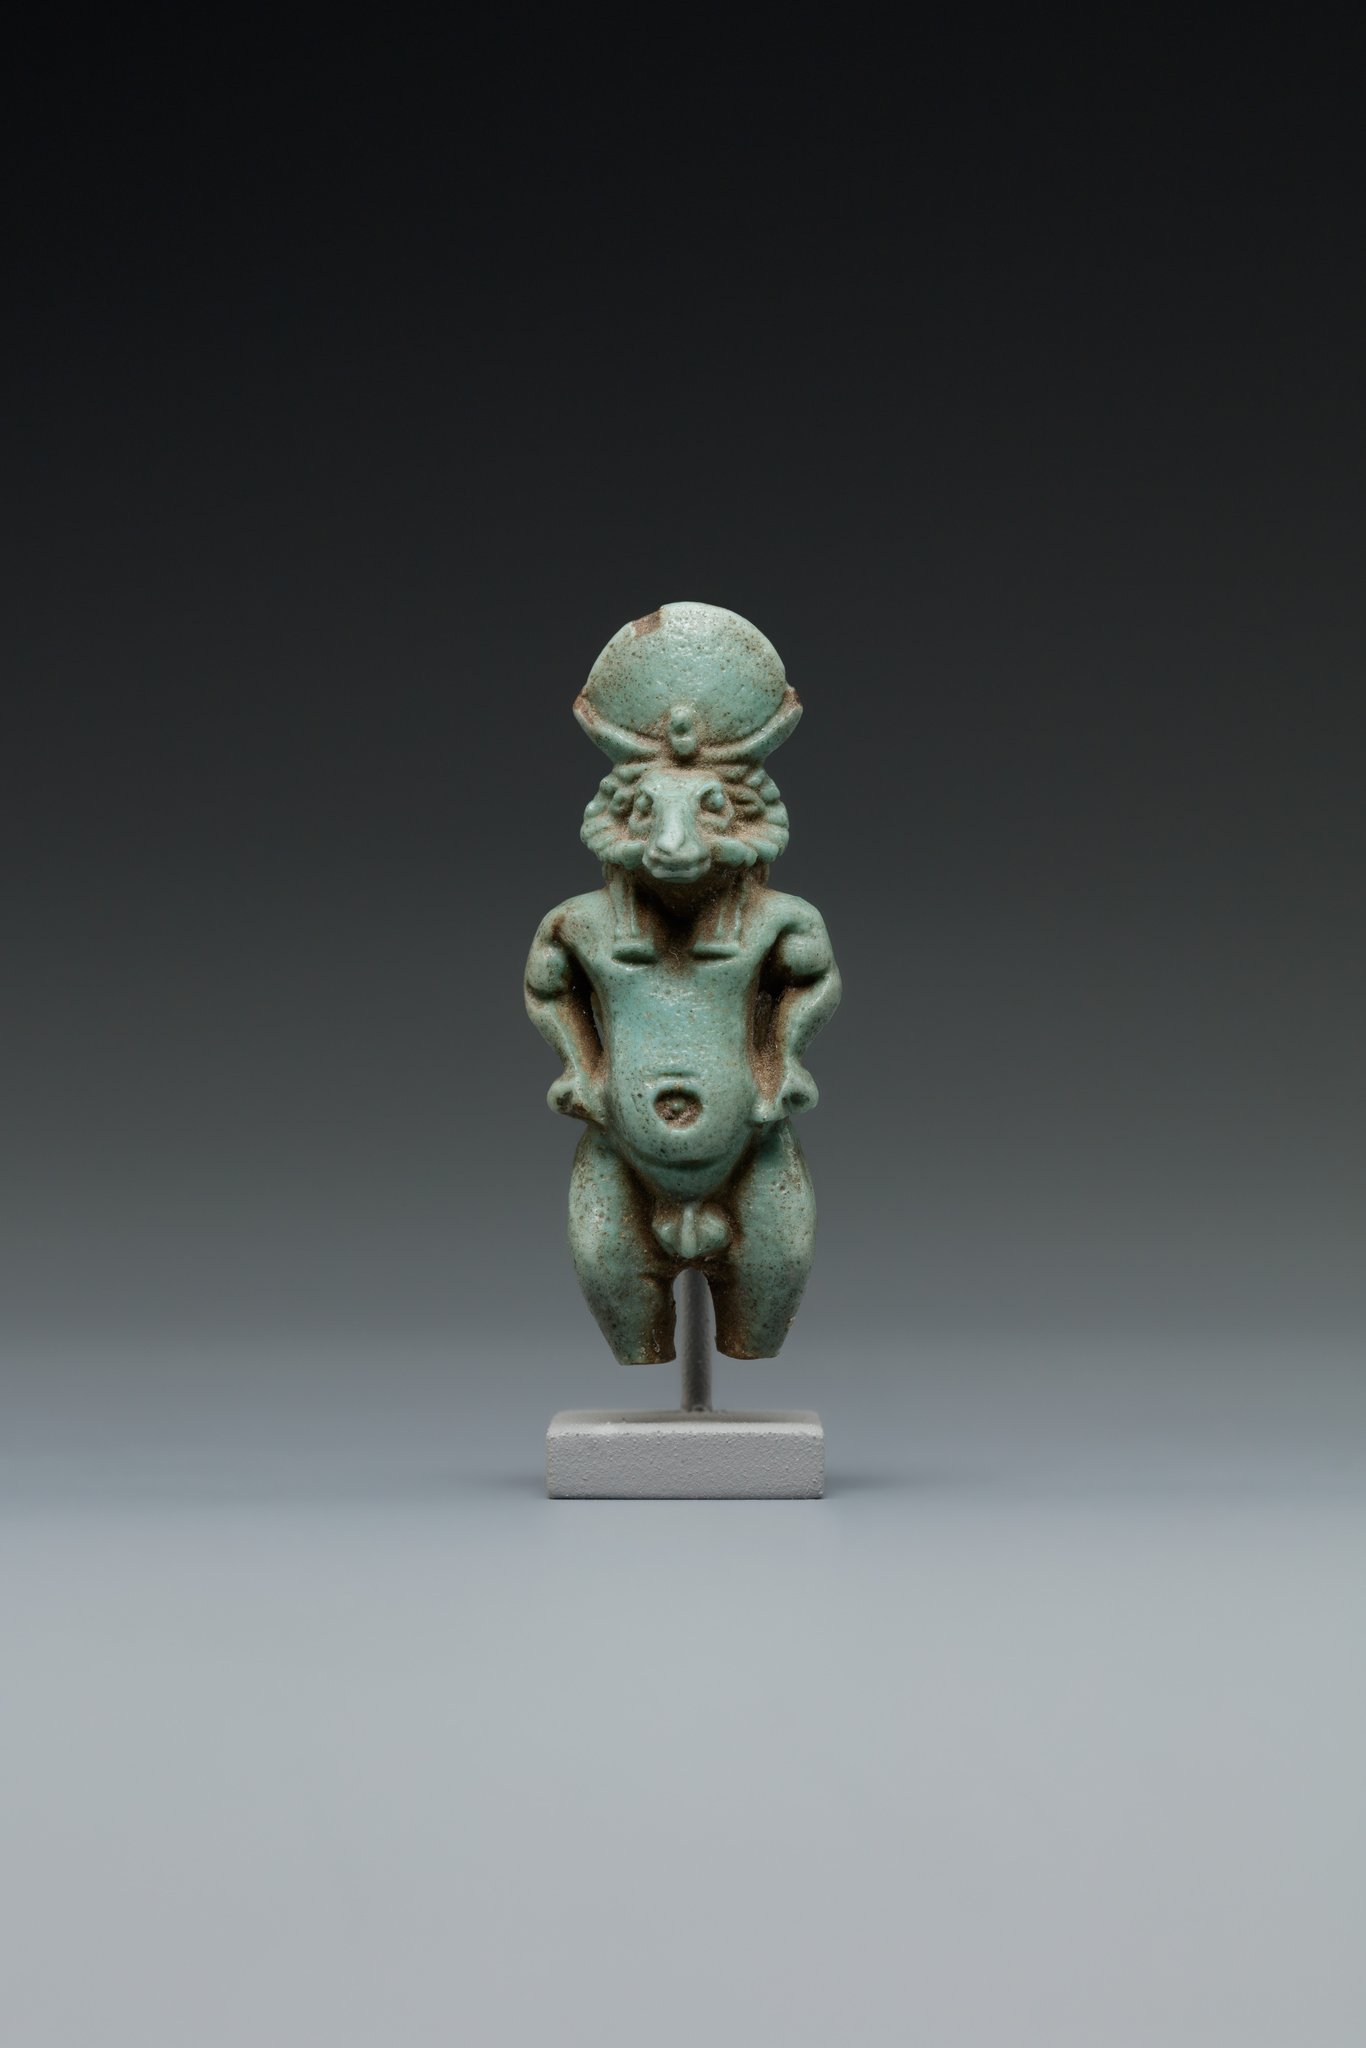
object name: amulet, hybrid god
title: Hybrid god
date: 664-332 BCE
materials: faience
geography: memphite region